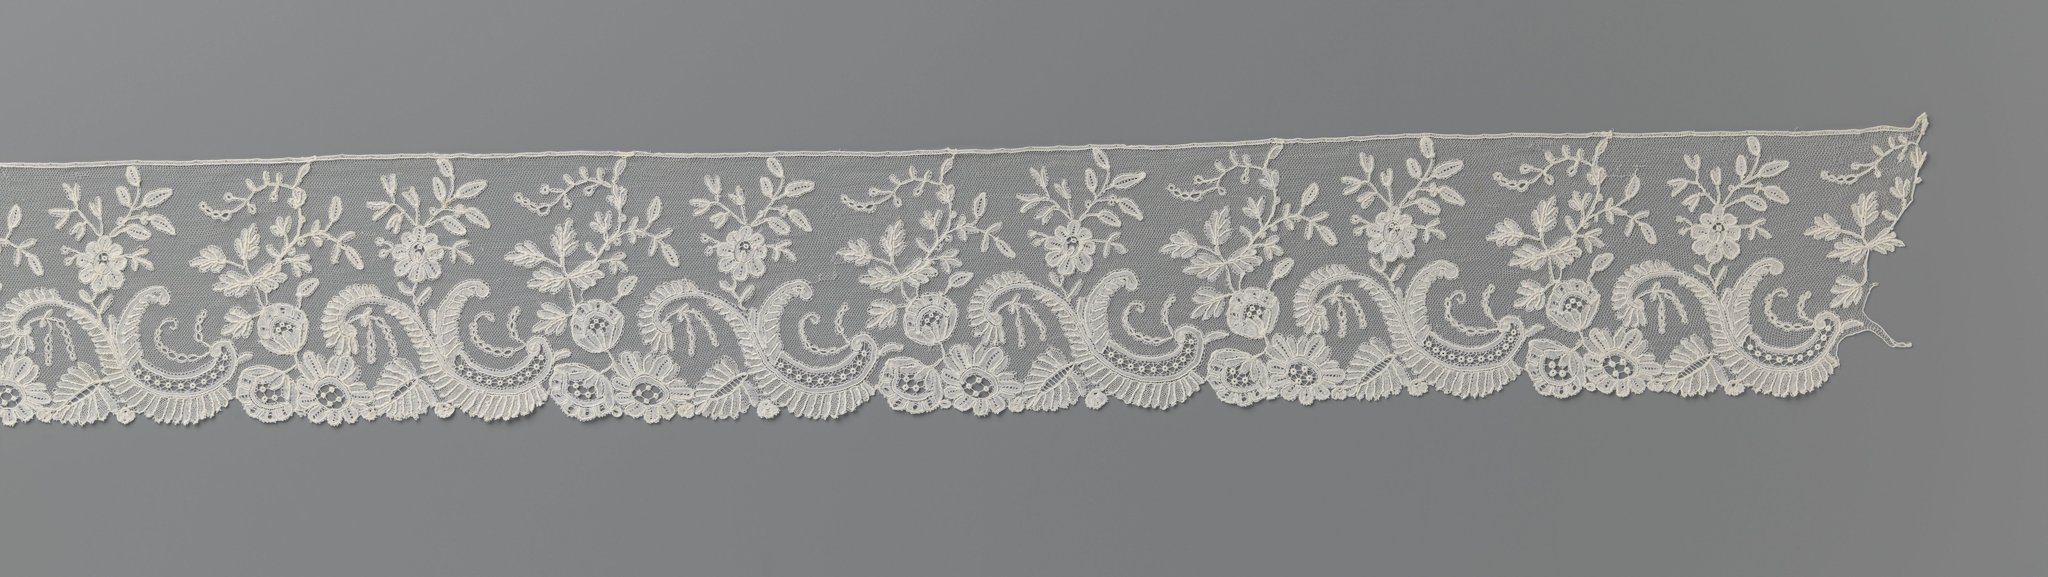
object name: strip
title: Strook gemengde kant met s-voluten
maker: Anonymous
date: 1875-1899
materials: linen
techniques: lace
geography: brussels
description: Strook naturelkleurige gemengde kant: Brusselse kloskant in combinatie met een naaldkantgrond, een fijne gaaskantgrond. Dit type kant staat ook bekend onder de naam: point d'Angleterre. Het lopende patroon is ijl van tekening en bestaat uit in elkaar passende c- en s-voluten. Grote rozen, en face en en profil, vormen met een blad en een c-voluut diepe schulpen. Fijne bladtakjes zijn naar de binnenzijde gekeerd.